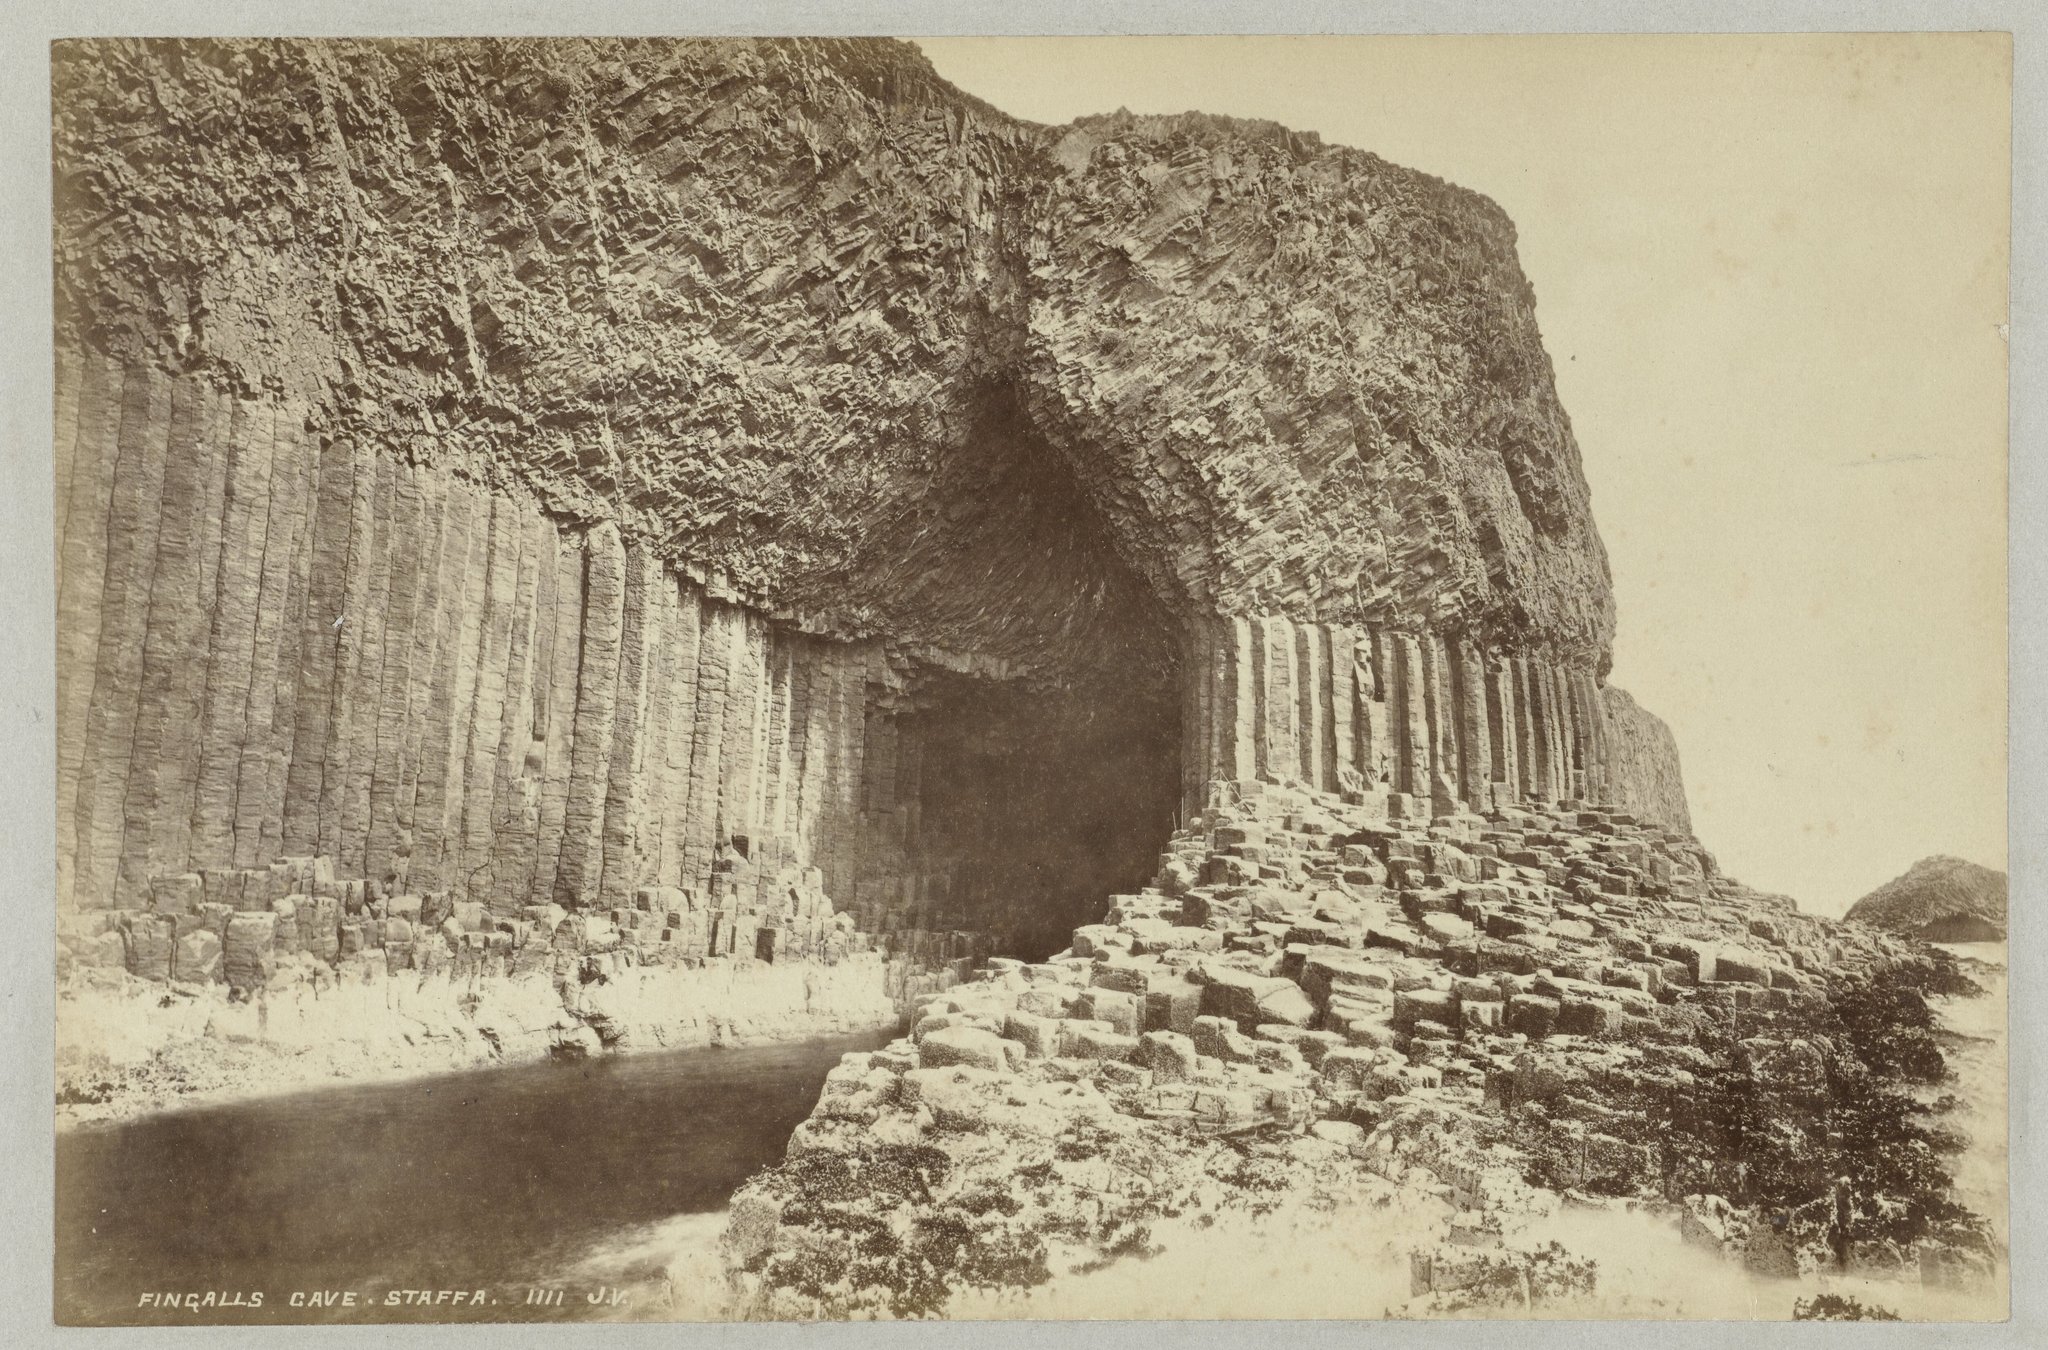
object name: photograph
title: Fingalls Cave, Staffa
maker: james valentine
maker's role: fotograaf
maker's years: 1815-1880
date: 1851-1880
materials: cardboard, paper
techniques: albumen print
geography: staffa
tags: cave, grotto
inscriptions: number: ‘1111’